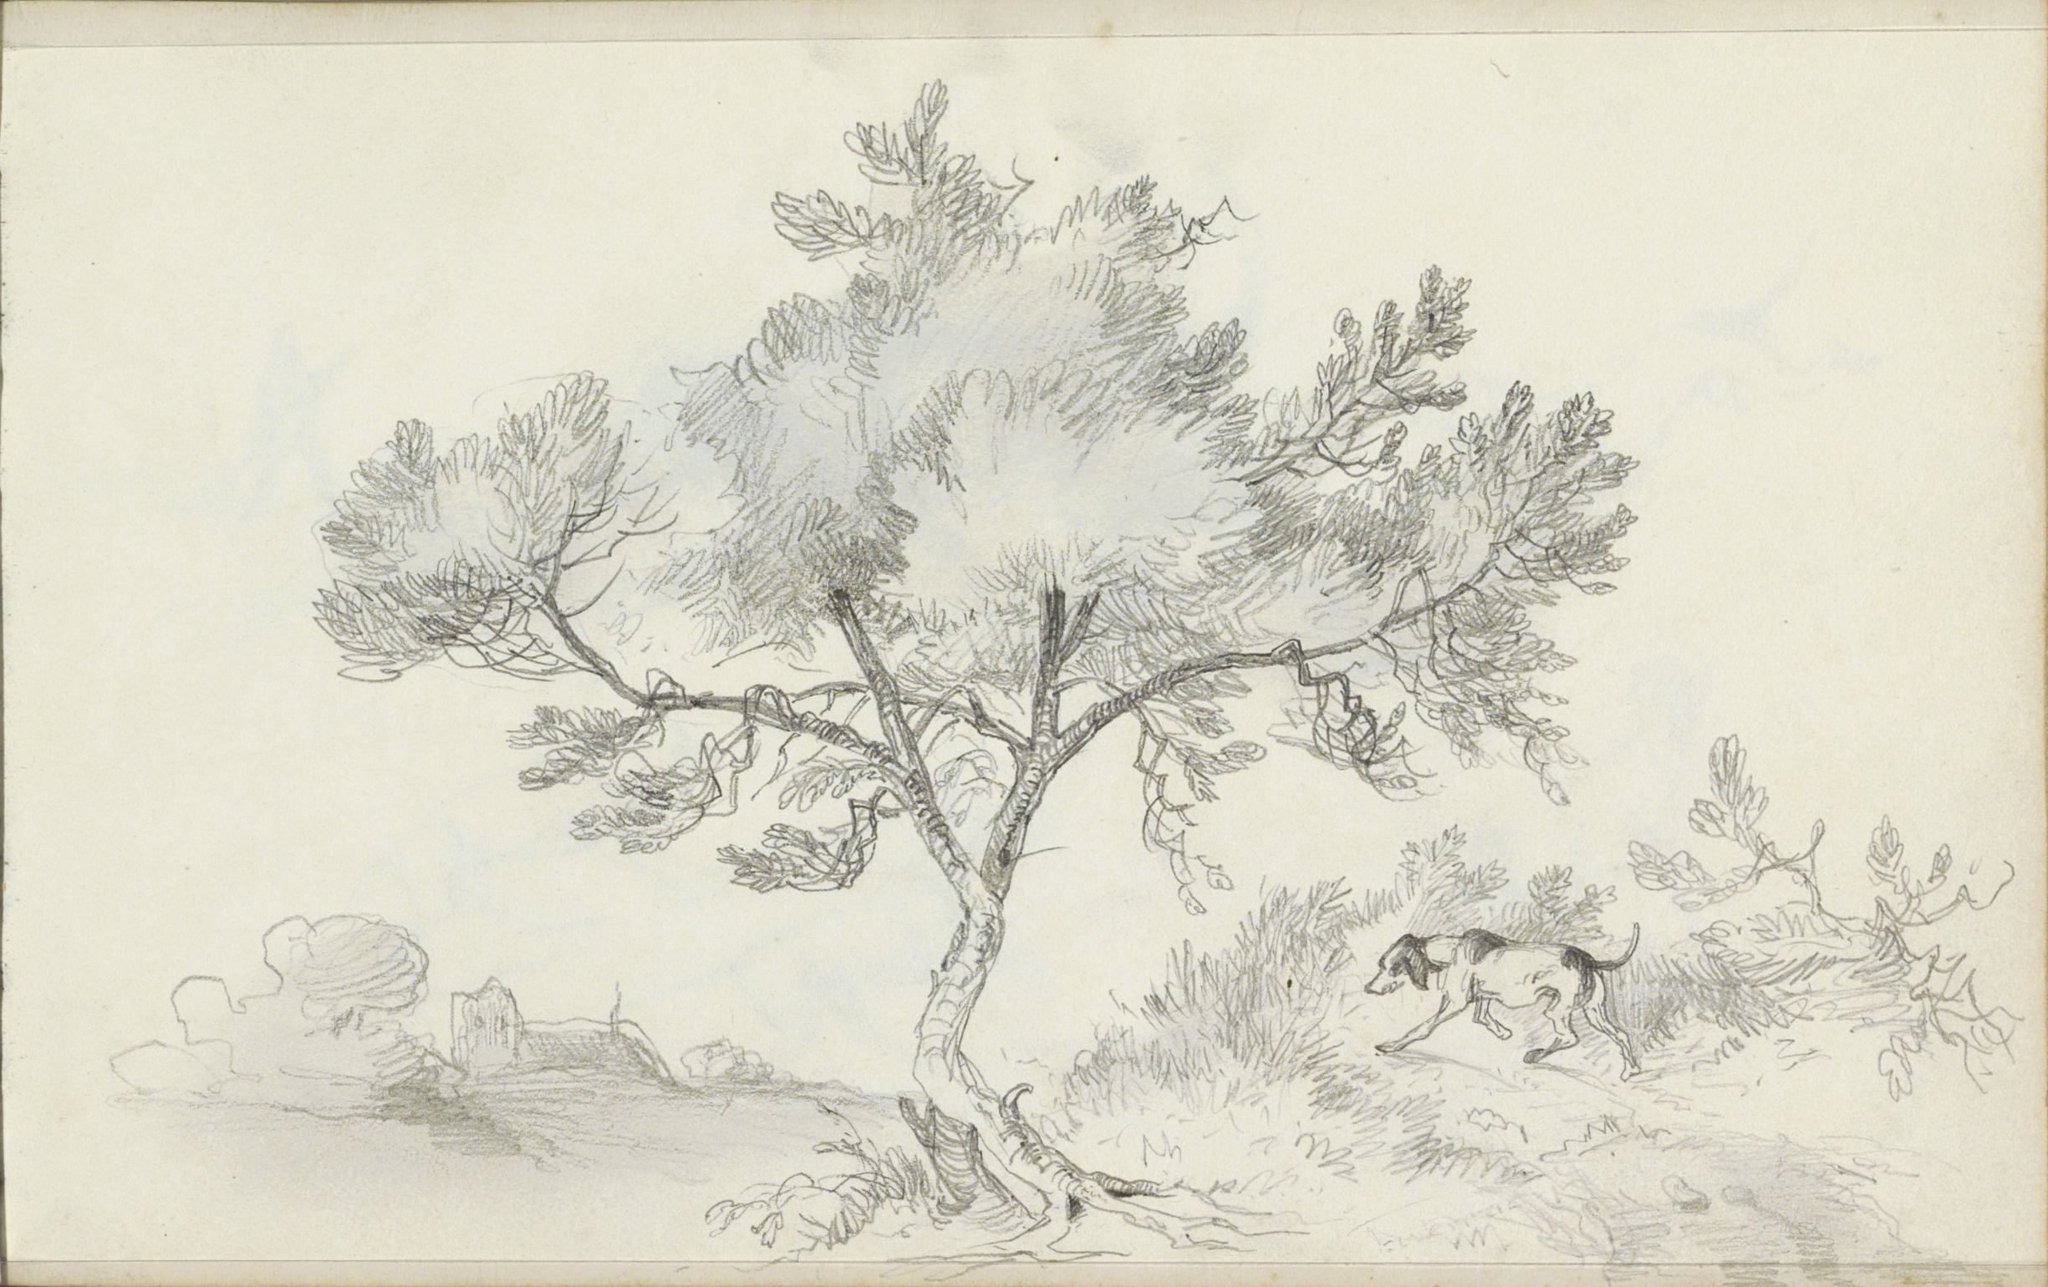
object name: sketchbook leaf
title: Landschap met een hond op een pad bij een boom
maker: johannes tavenraat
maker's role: draughtsman, painter, print maker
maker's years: 1809-1881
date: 1843-1844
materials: paper, pencil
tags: city-view, and landscape with man-made constructions, trees, road, path, dog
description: Op de achtergrond een huis. Blad 27 recto uit een schetsboek met 38 bladen.